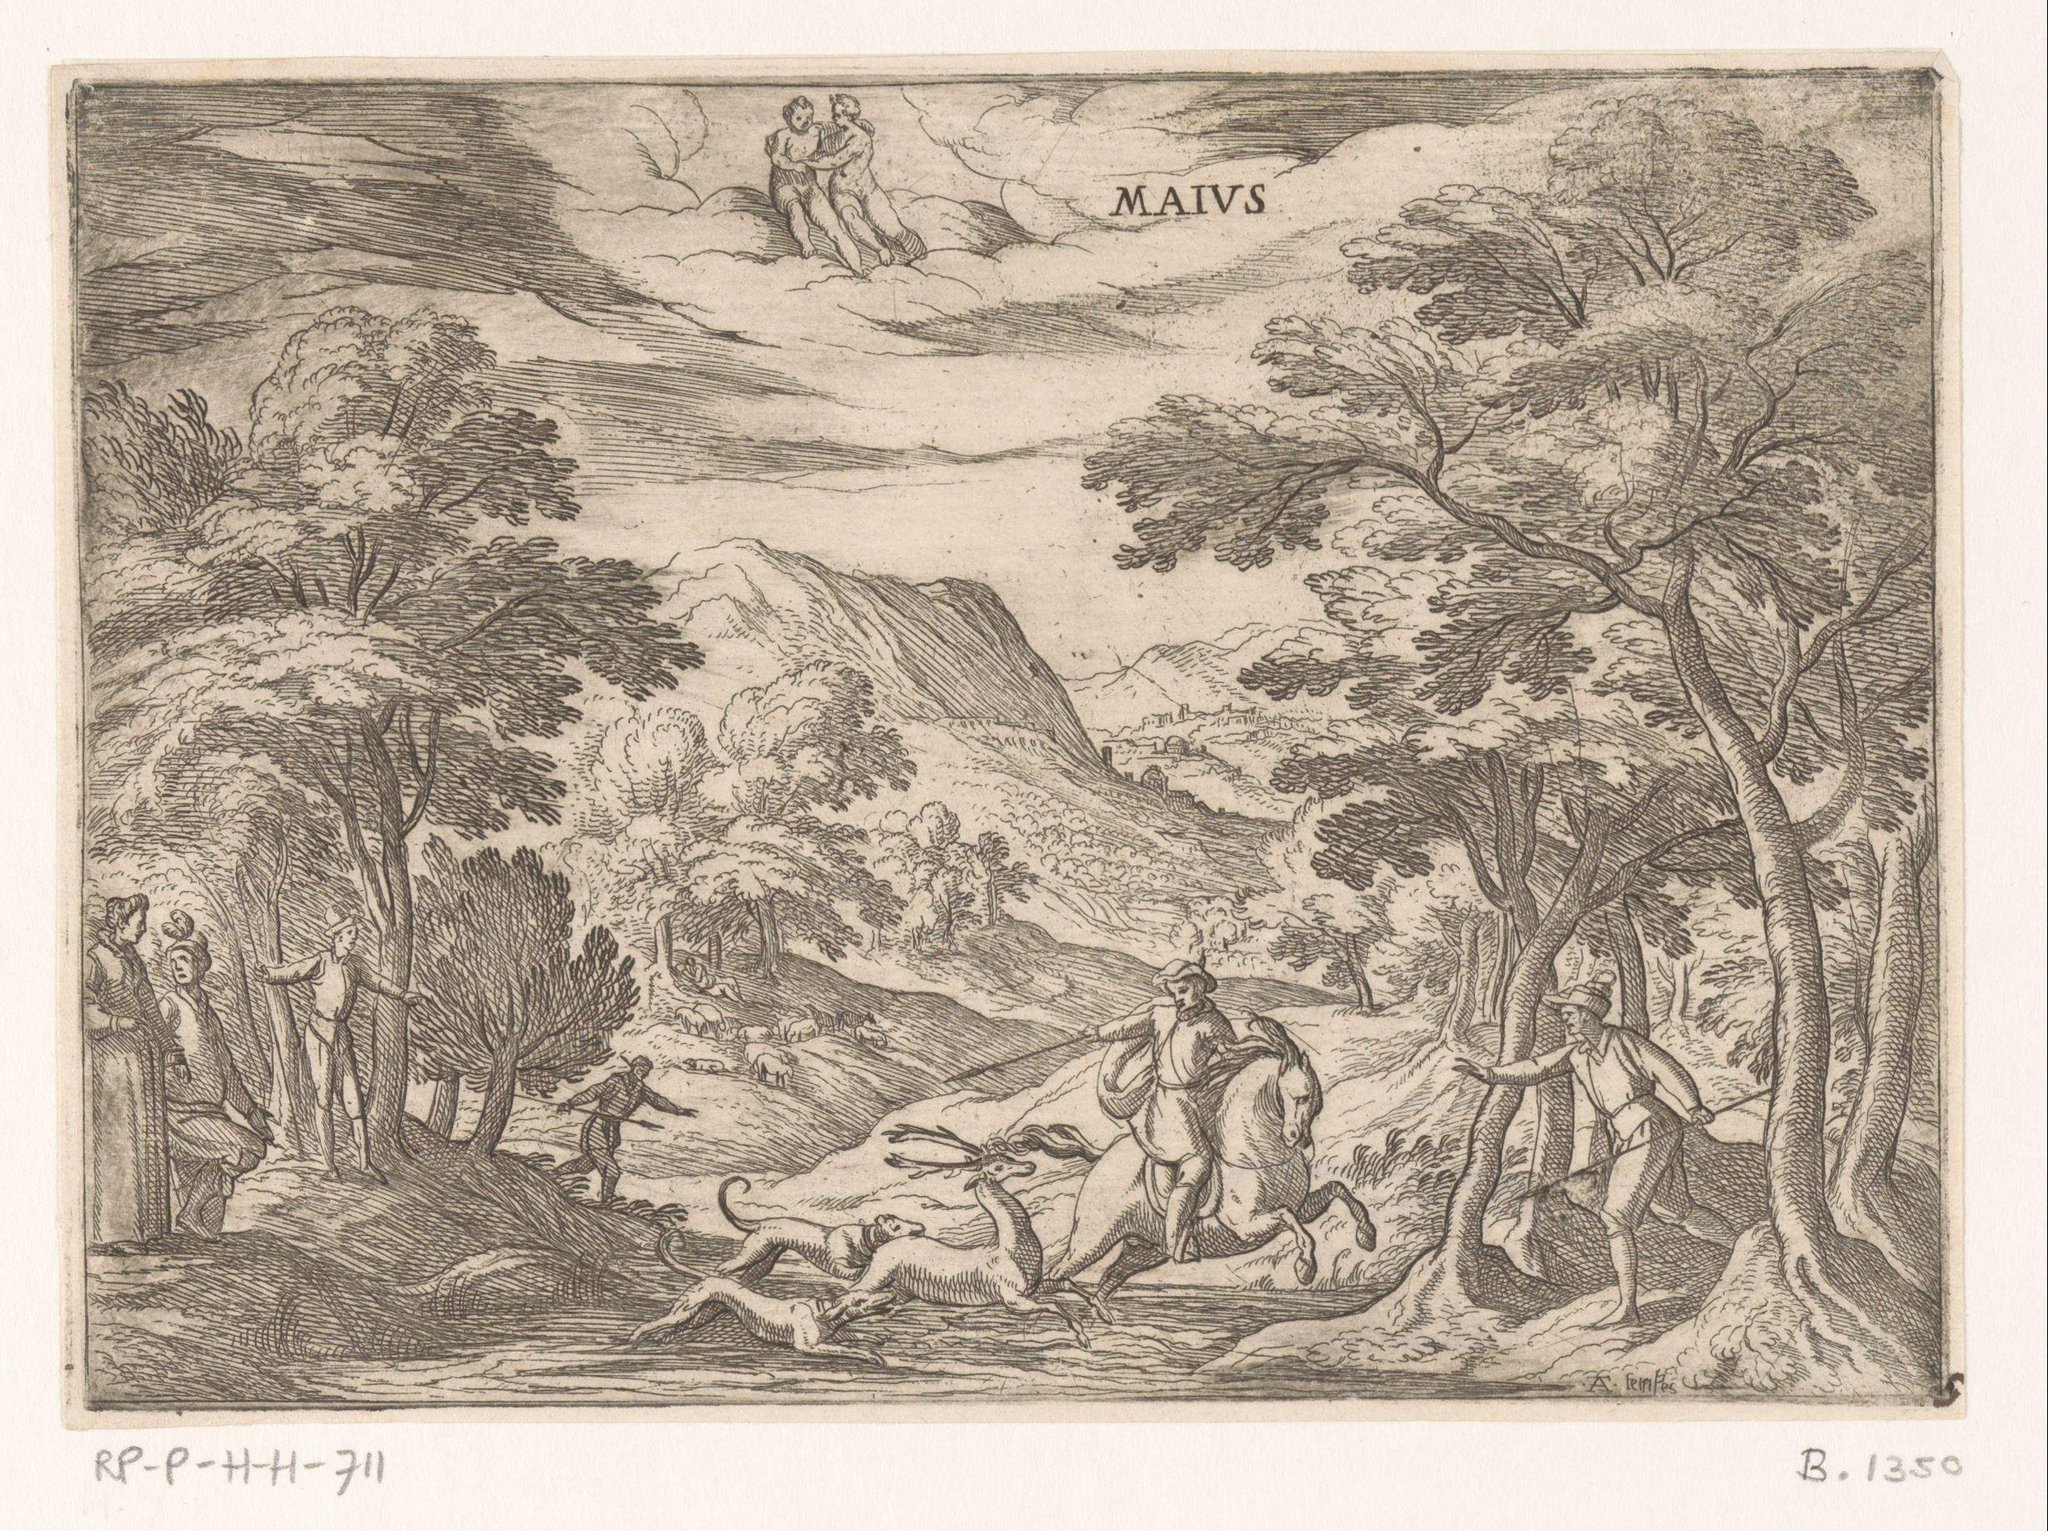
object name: print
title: De twaalf maanden (deel 2)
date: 1575-1613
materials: paper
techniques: etching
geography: rome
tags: landscape symbolizing may, stag-hunting, hunters hunting (n.b.: in 1988-1990 this notation denoted the concept of 43c11421 'hunters resting during the hunt'), gemini (zodiacal sign of may)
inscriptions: collector's mark: ‘Hinloopen’, number: ‘5’, collector's mark: Lugt 11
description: Landschap dat de maand mei verbeeldt. Landschap met jagers en jachthonden jagend op een hert. Midden boven het symbool voor het sterrenbeeld tweelingen.